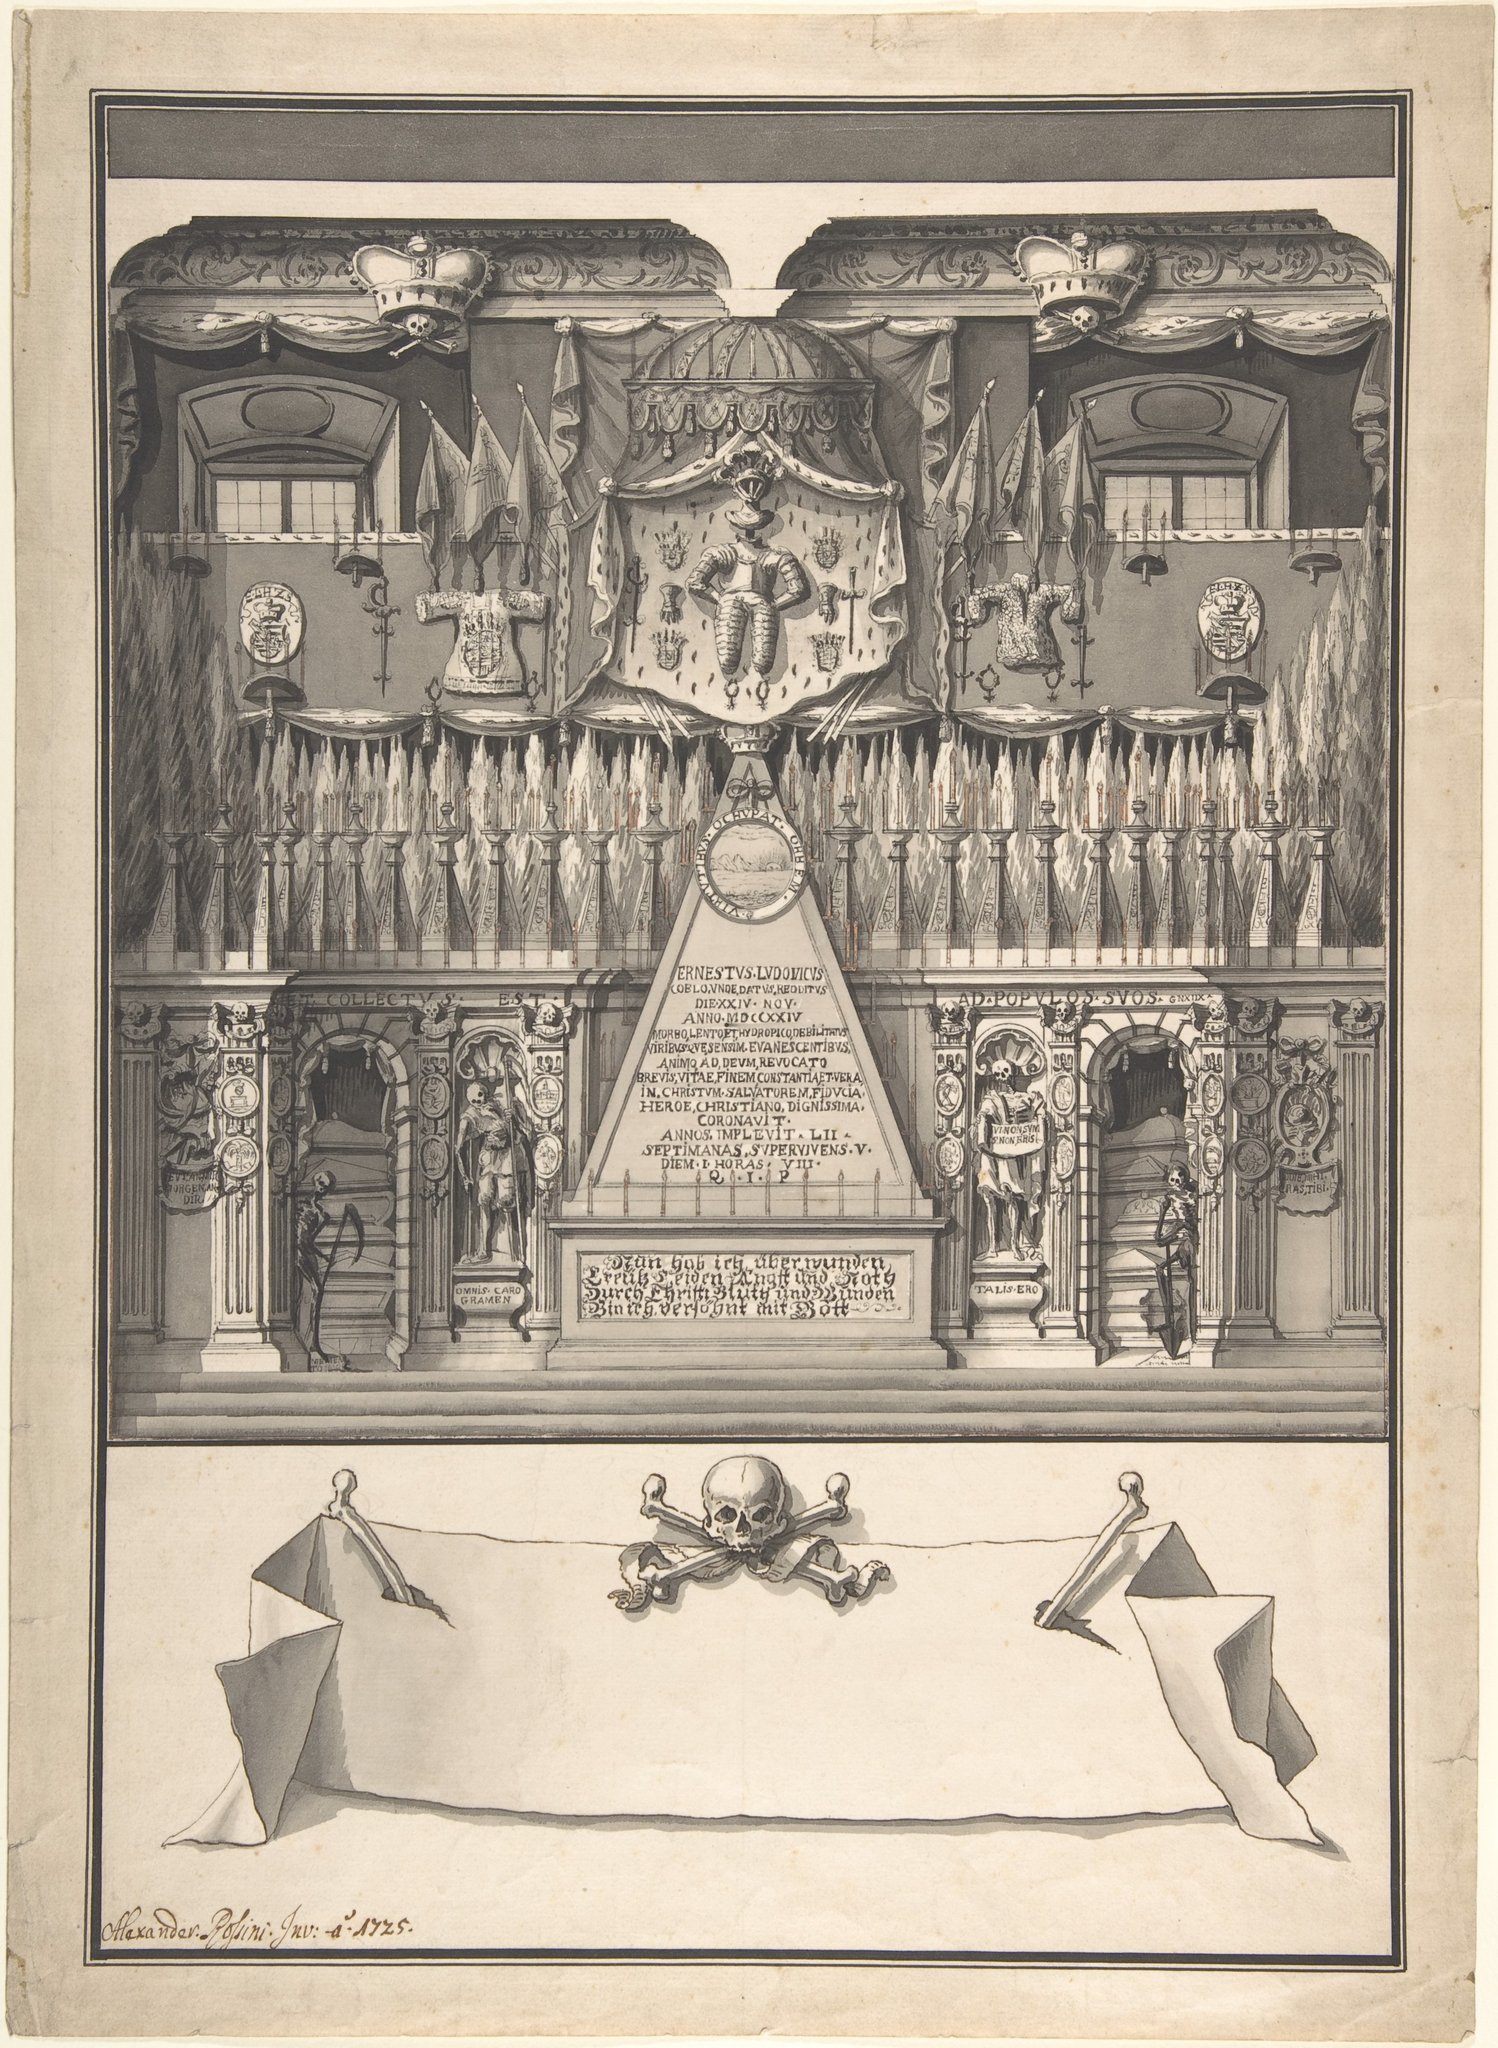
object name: drawing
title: Memorial Decoration for the Interior of a Building to Honor the Deceased Ernst Ludwig, 1725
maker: alessandro rossini (reported active 1702-1736)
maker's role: artist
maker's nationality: italian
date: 1702-1736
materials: gouache, ink, drawing material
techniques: brush, highlighting, pen, wash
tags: interiors,armor,skeletons,skulls